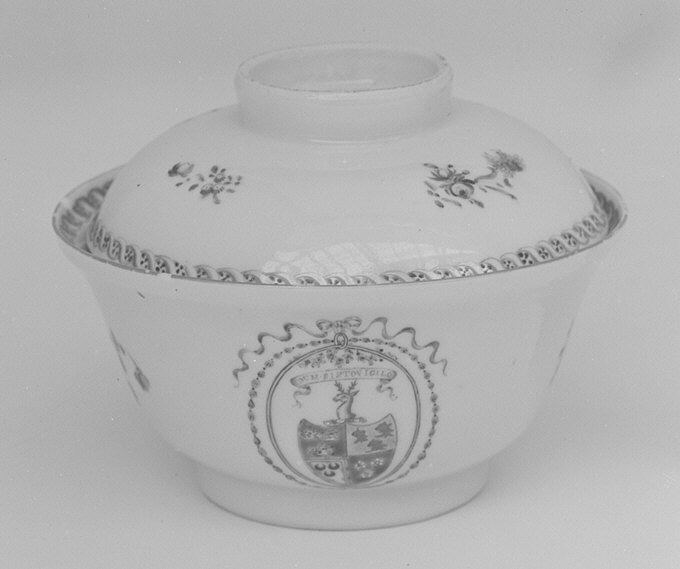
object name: sugar bowl with cover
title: Sugar bowl with cover (part of a service)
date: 1770-1785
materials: hard paste porcelain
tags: coat of arms